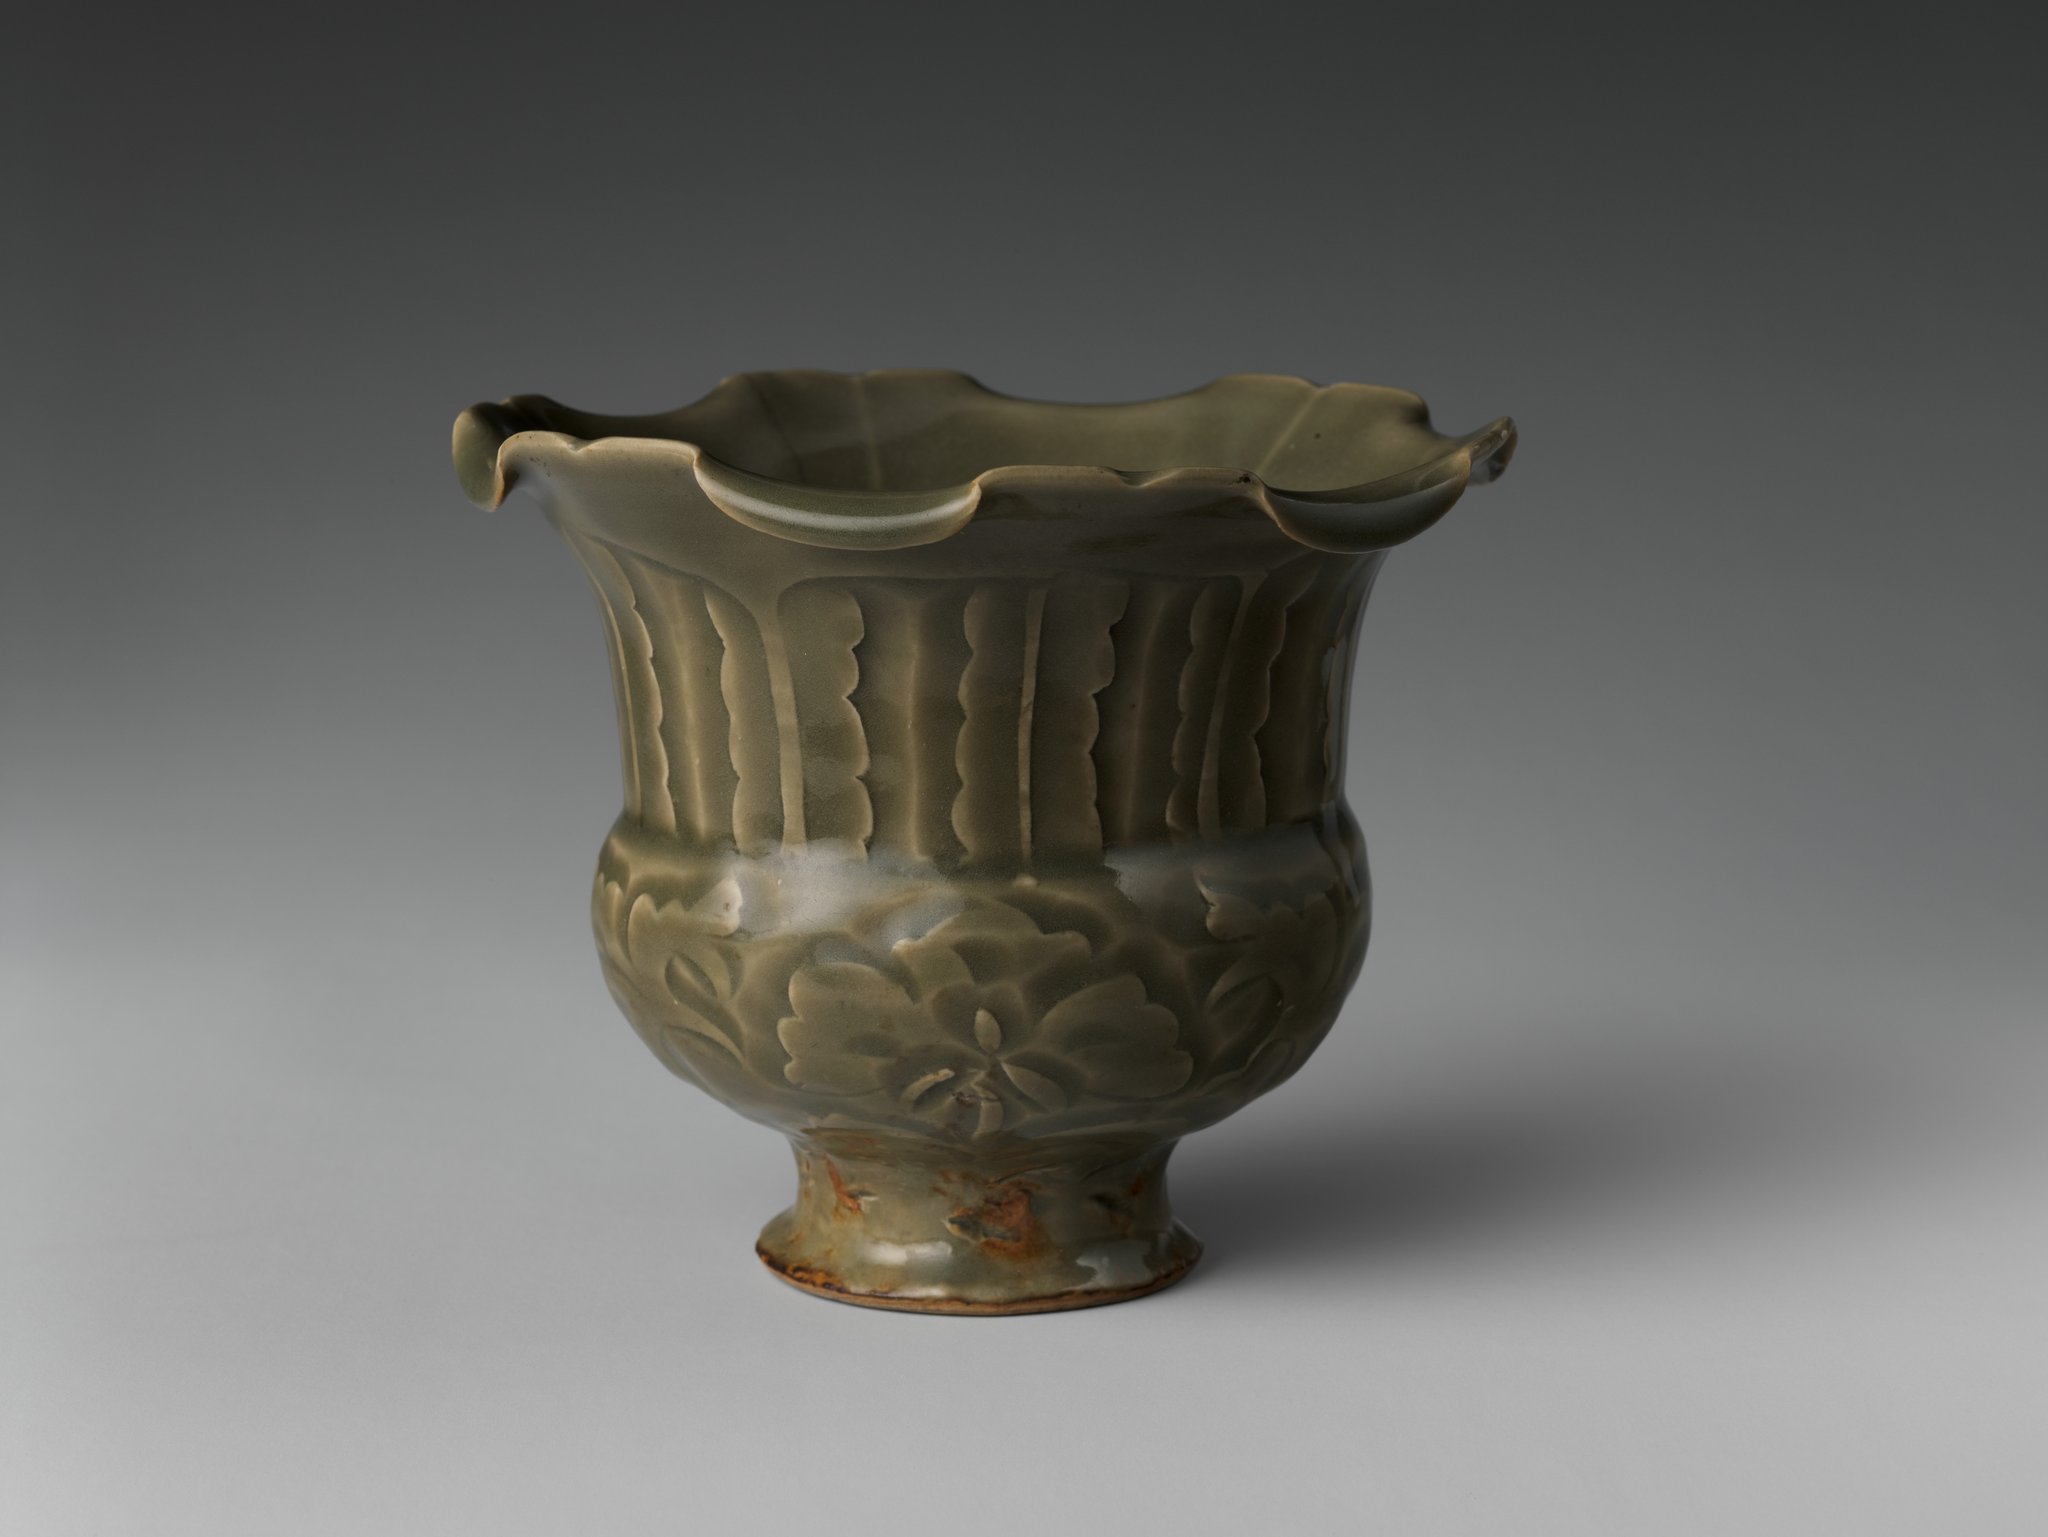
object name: jar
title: Jar with Peony Scroll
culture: chinese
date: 1001-1200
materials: ceramic glaze, glaze, stoneware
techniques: carving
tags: peonies